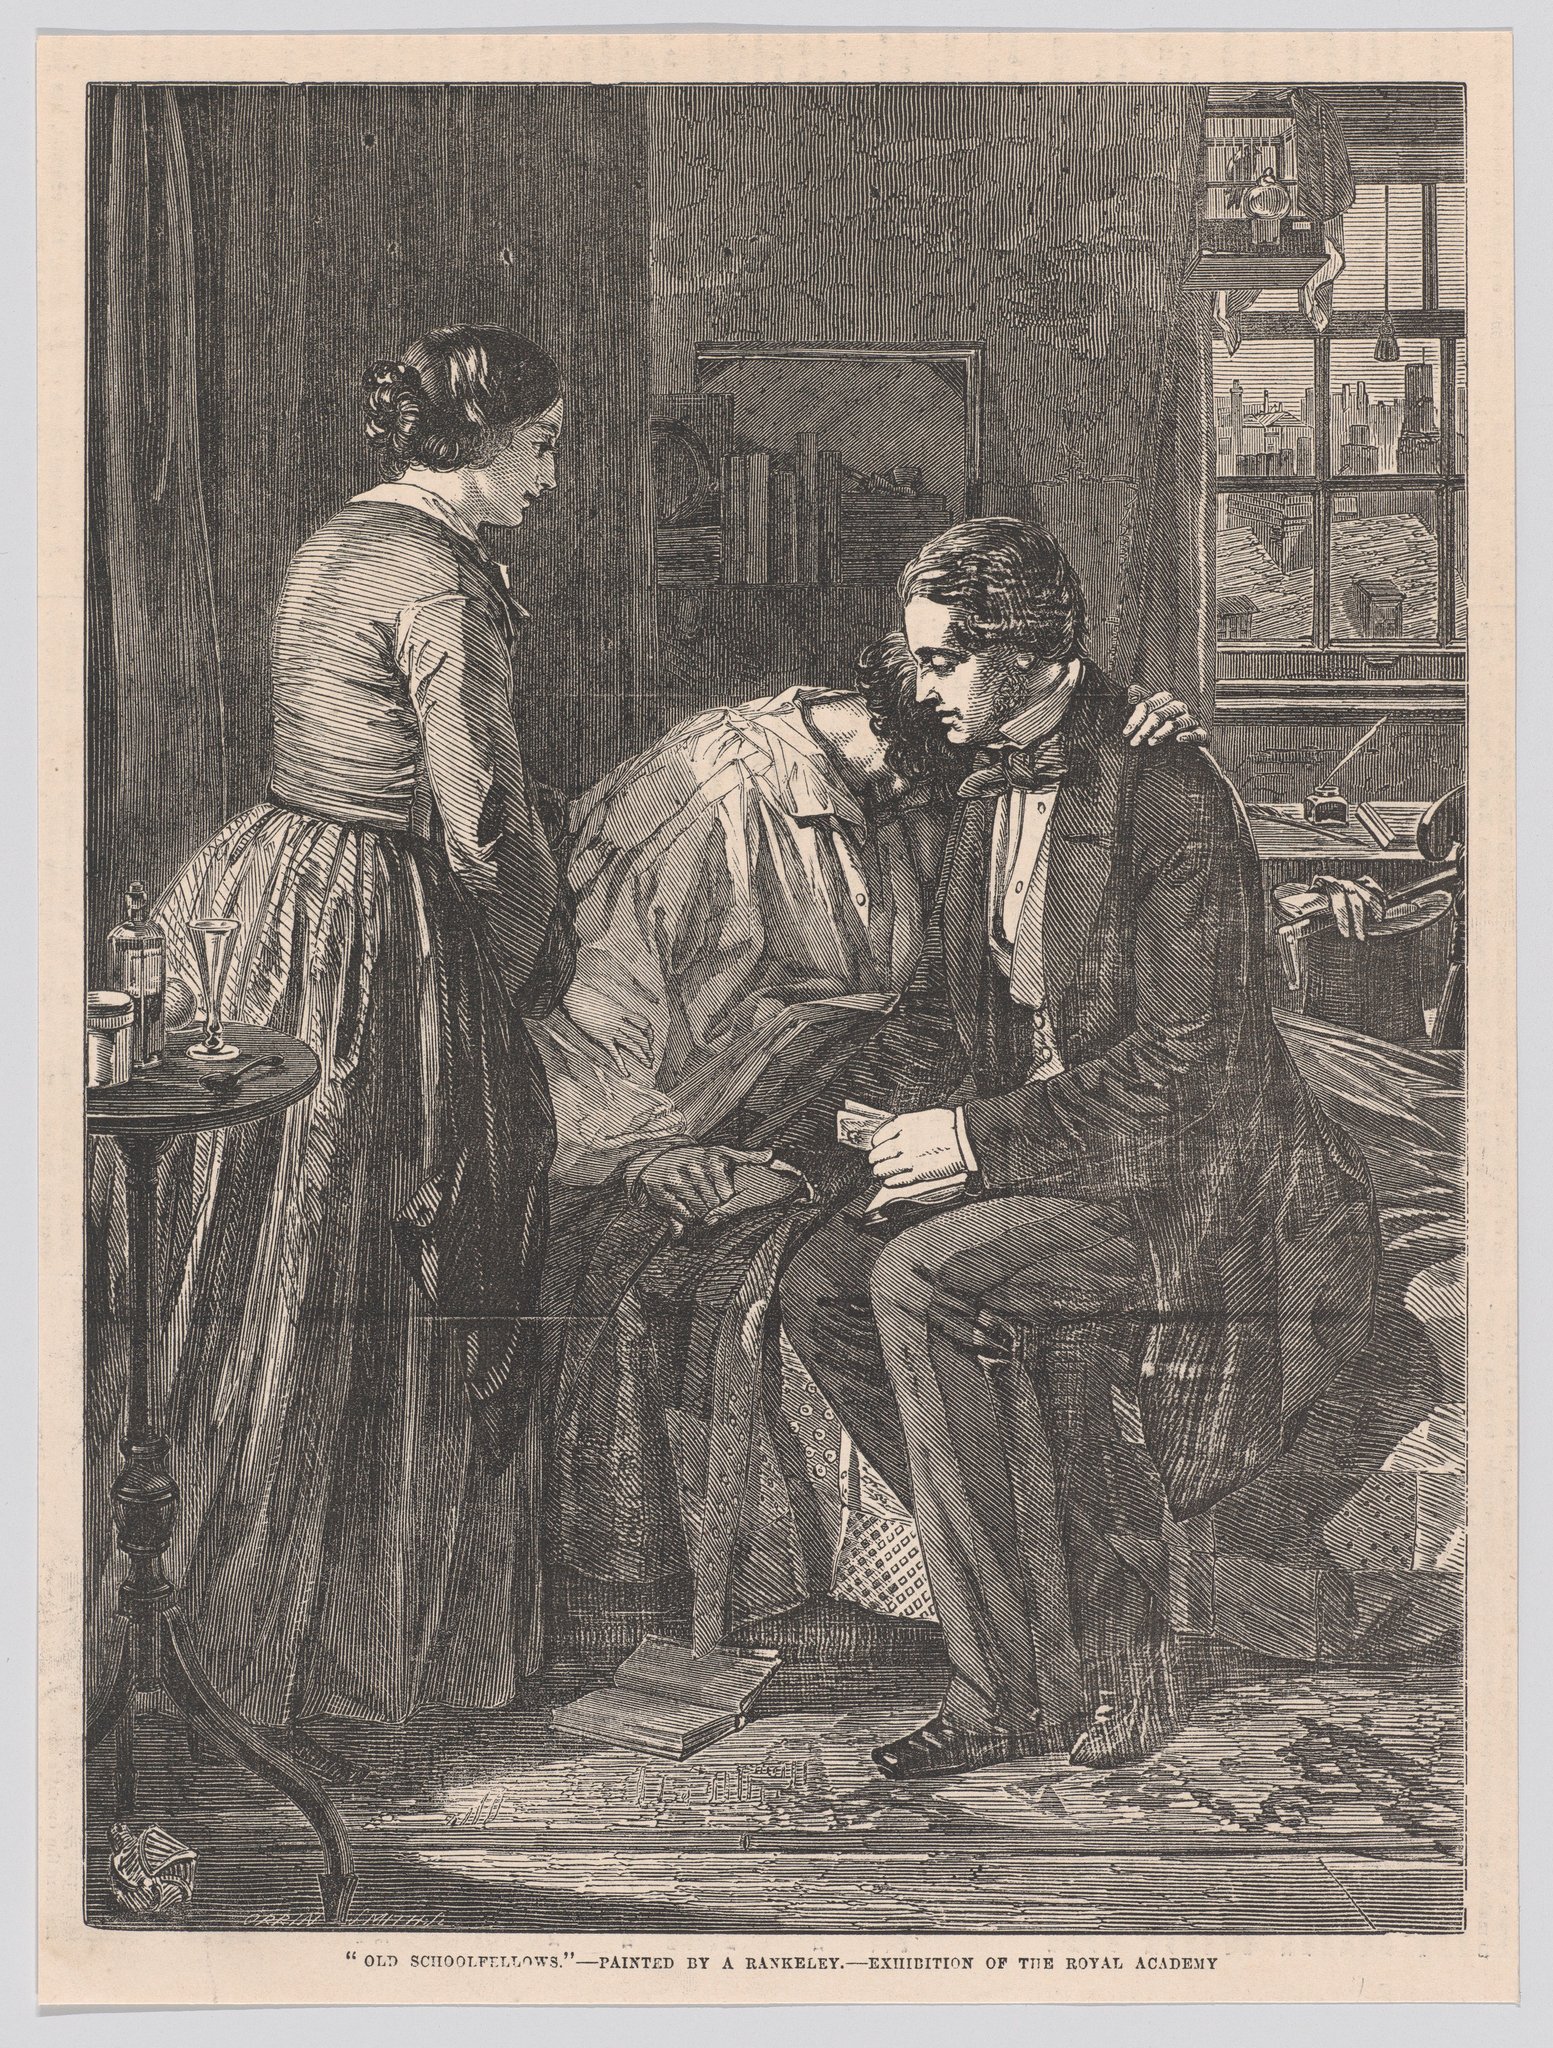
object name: print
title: Old Schoolfellows, from "Illustrated London News"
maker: harvey orrin smith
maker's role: engraver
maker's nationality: british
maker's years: 1847-1870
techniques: engraving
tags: interiors,illness,men,women